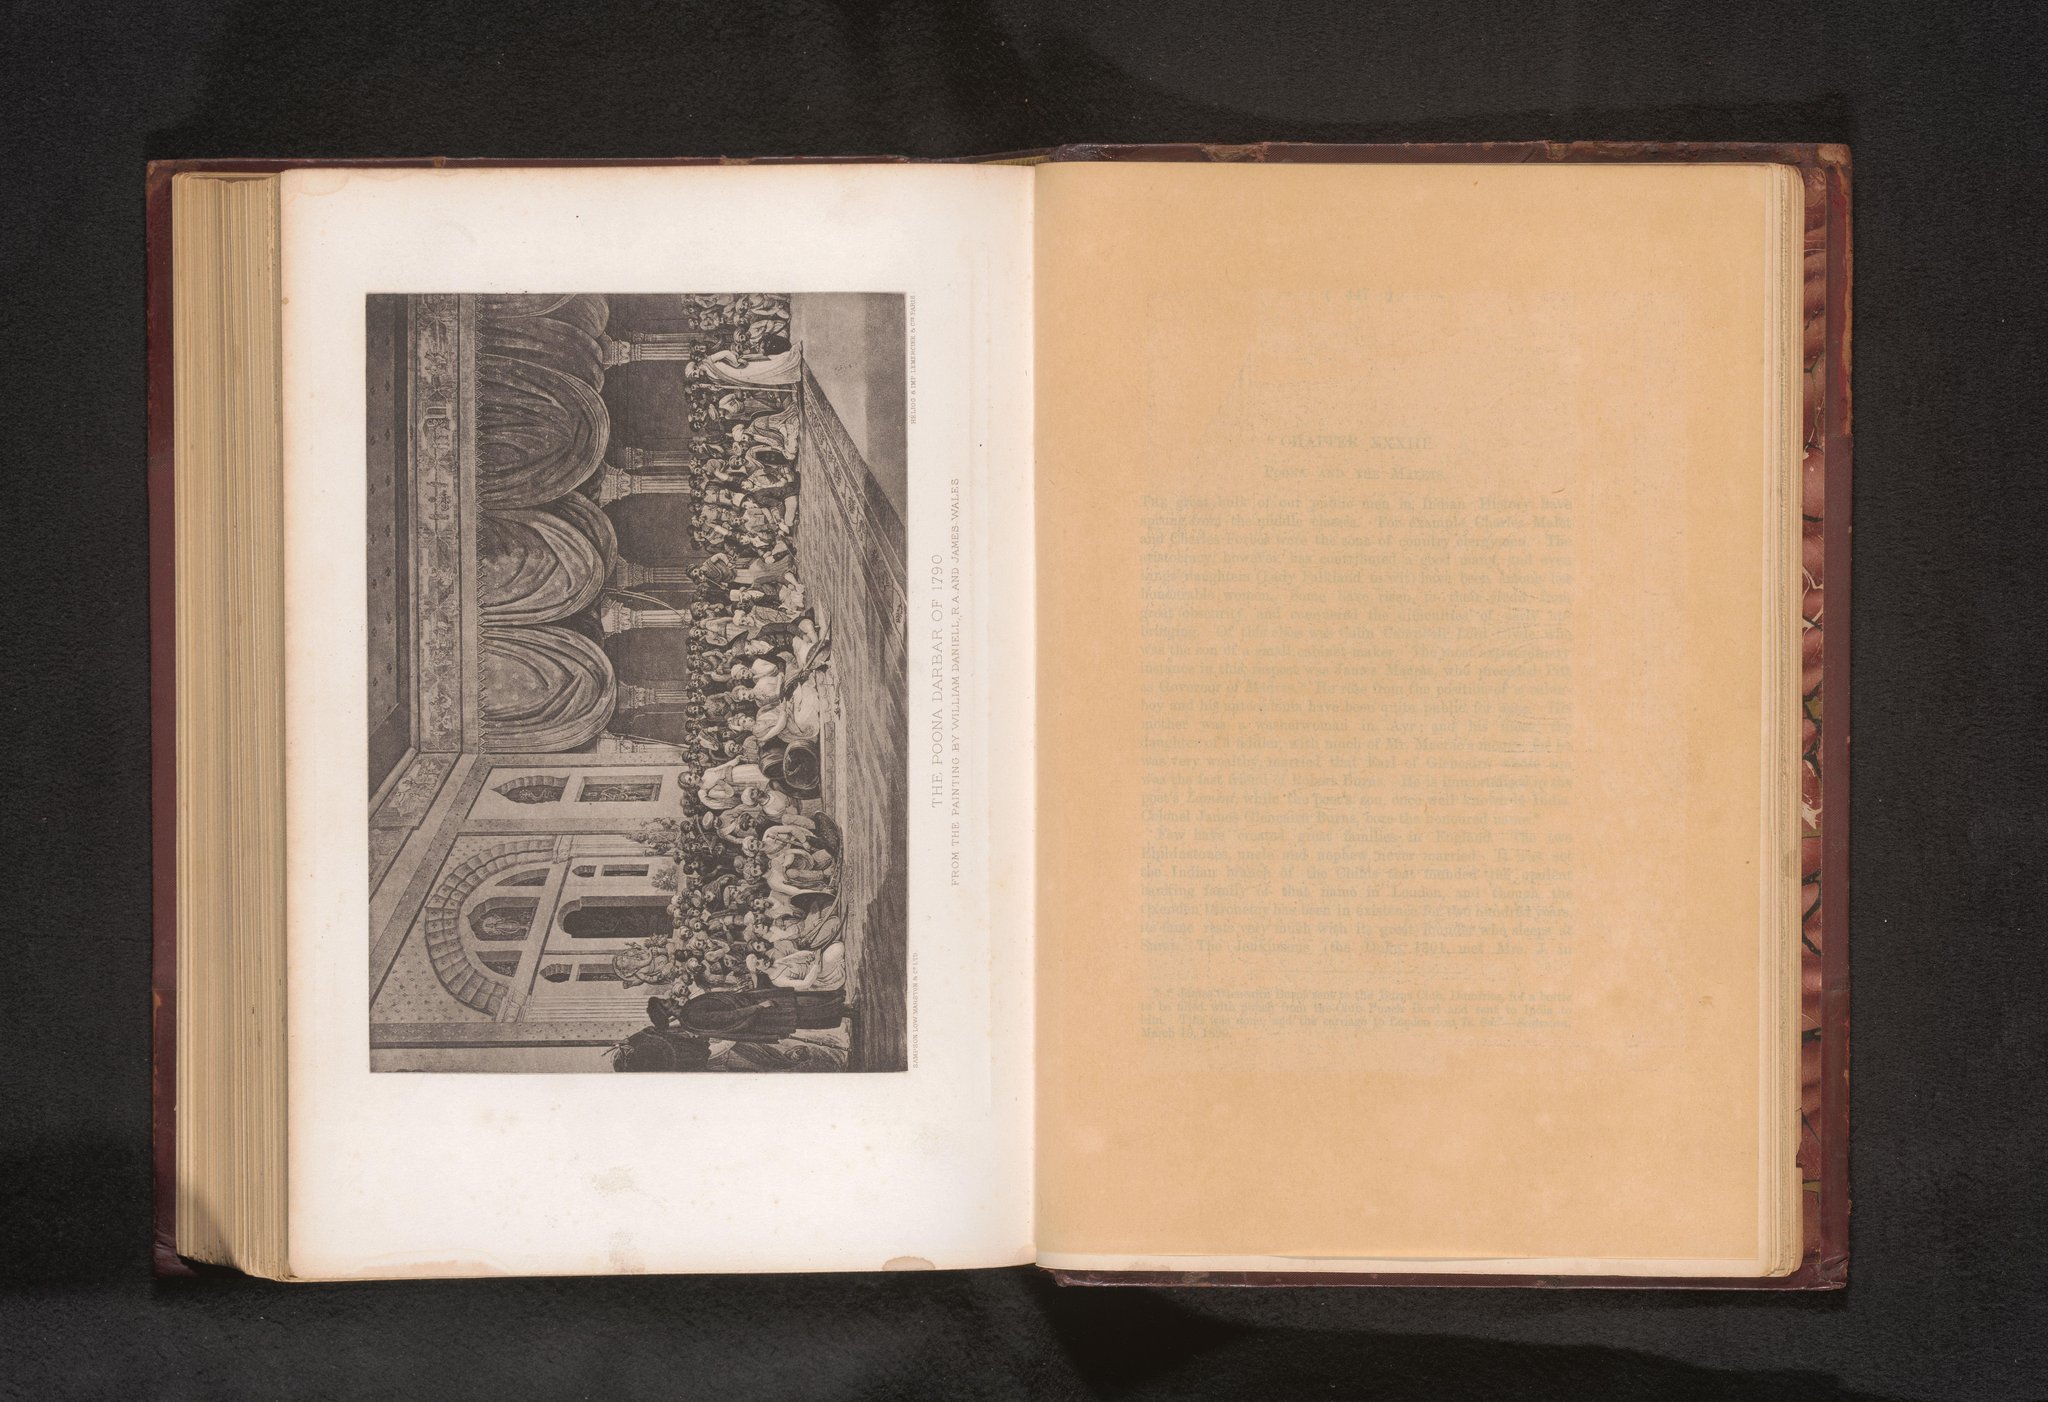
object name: page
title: Photo reproduction of a painting depicting the durbar of Pune, Maharashtra, India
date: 1883-1893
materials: paper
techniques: photoaquatint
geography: paris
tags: family of a ruler, and court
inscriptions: signature: ‘SAMPSON LOW MARSTON & CO. LTD/ HÉLIOG & IMP LEMERCIER & CIE. PARIS’, caption: ‘THE POONA DARBAR OF 1790/ FROM THE PAINTING BY WILLIAM DANIELL, R.A. AND JAMES WALES’